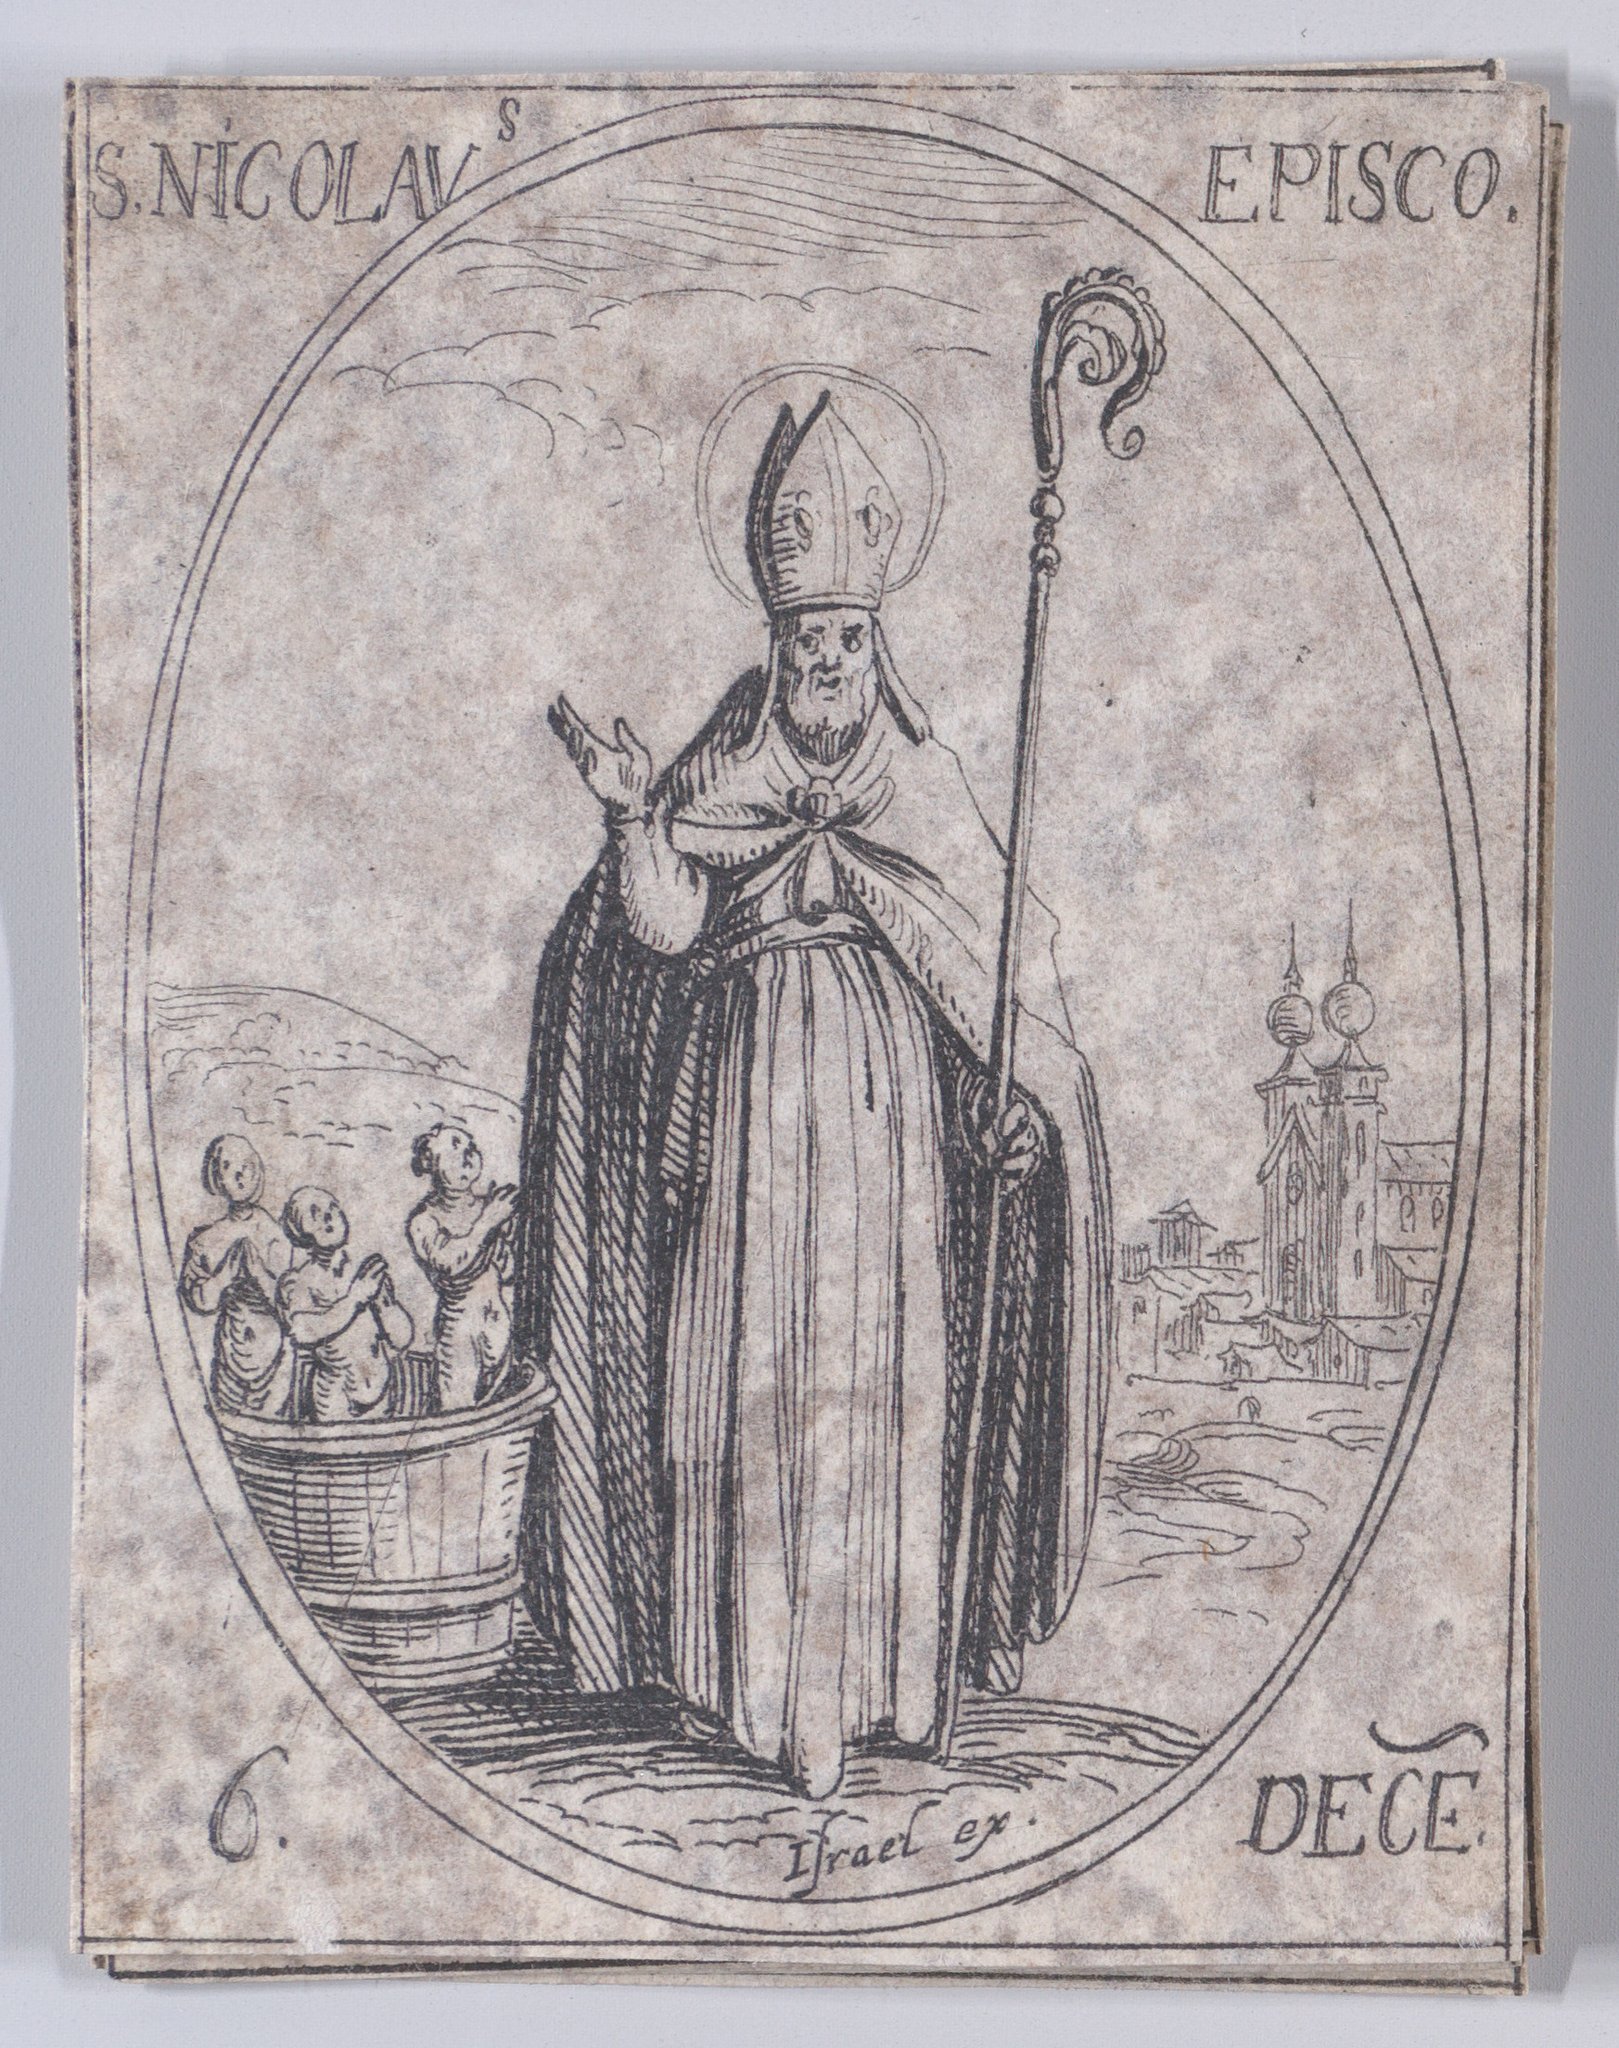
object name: print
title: S. Nicolas, évêque (St. Nicholas, Bishop), December 6th, from "Les Images De Tous Les Saincts et Saintes de L'Année" (Images of All of the Saints and Religious Events of the Year)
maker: jacques callot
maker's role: artist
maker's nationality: french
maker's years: 1592-1635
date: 1636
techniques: etching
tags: men,bishops,saints